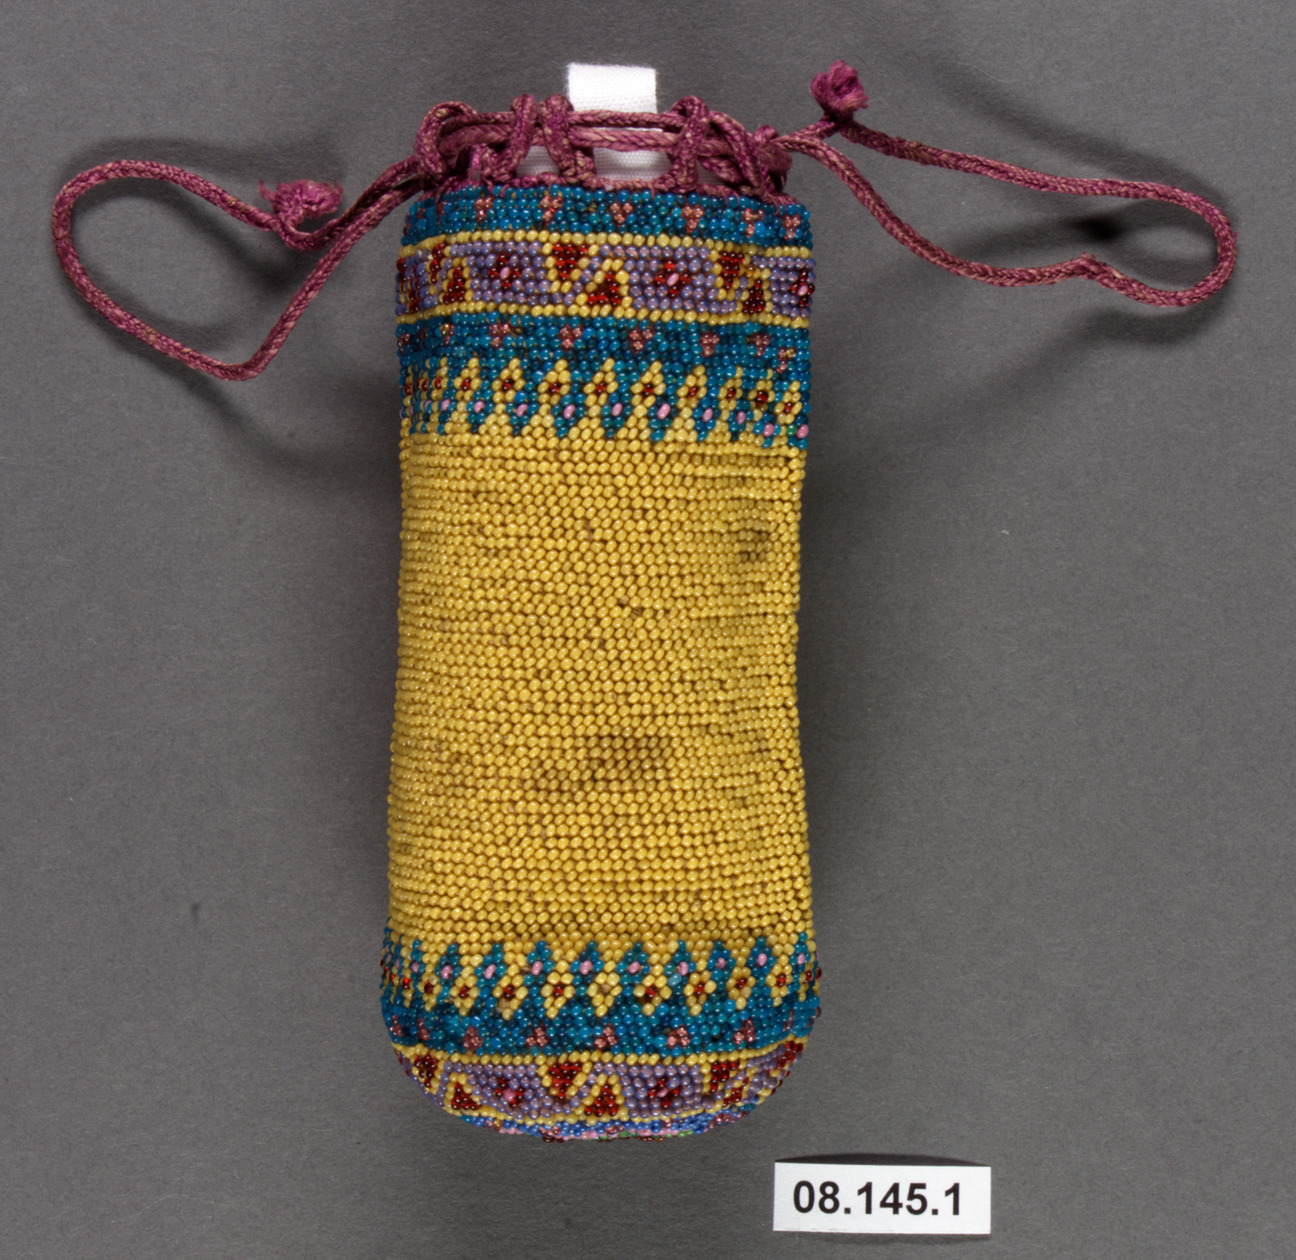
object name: storage bag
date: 1801-1900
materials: glass, silk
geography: iran